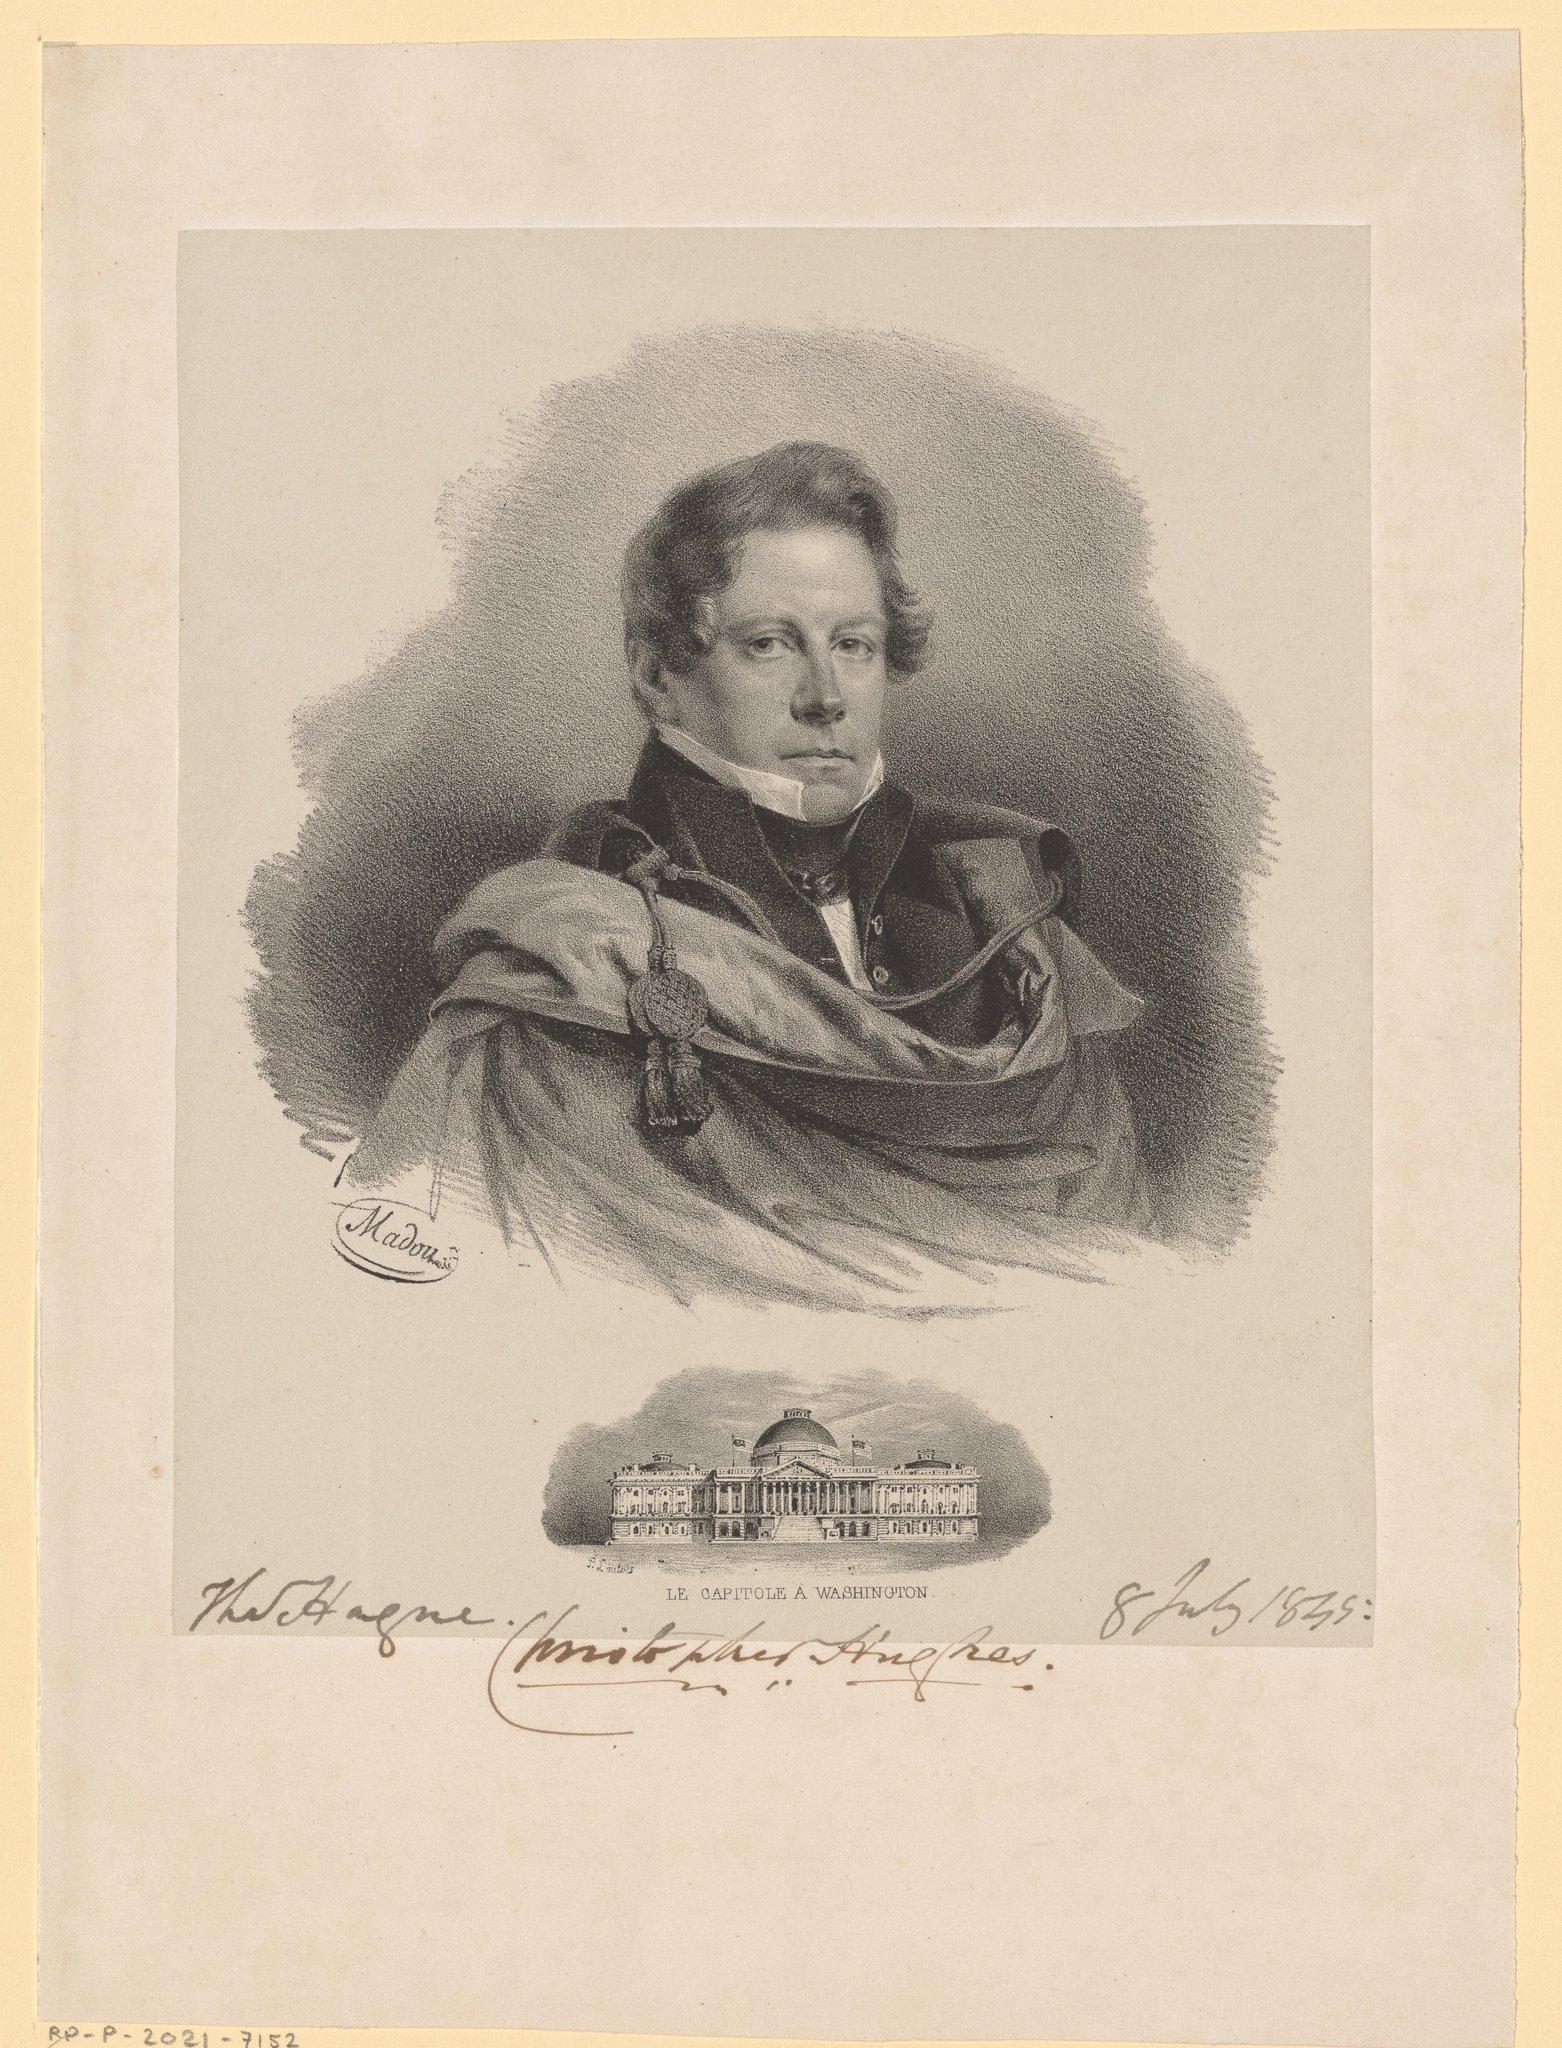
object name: print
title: Portret van Christopher Hughes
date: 1845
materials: paper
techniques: lithograph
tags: historical persons, diplomacy, diplomat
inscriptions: inscription: ‘[...] Christopher Hughes 8 July 1845’